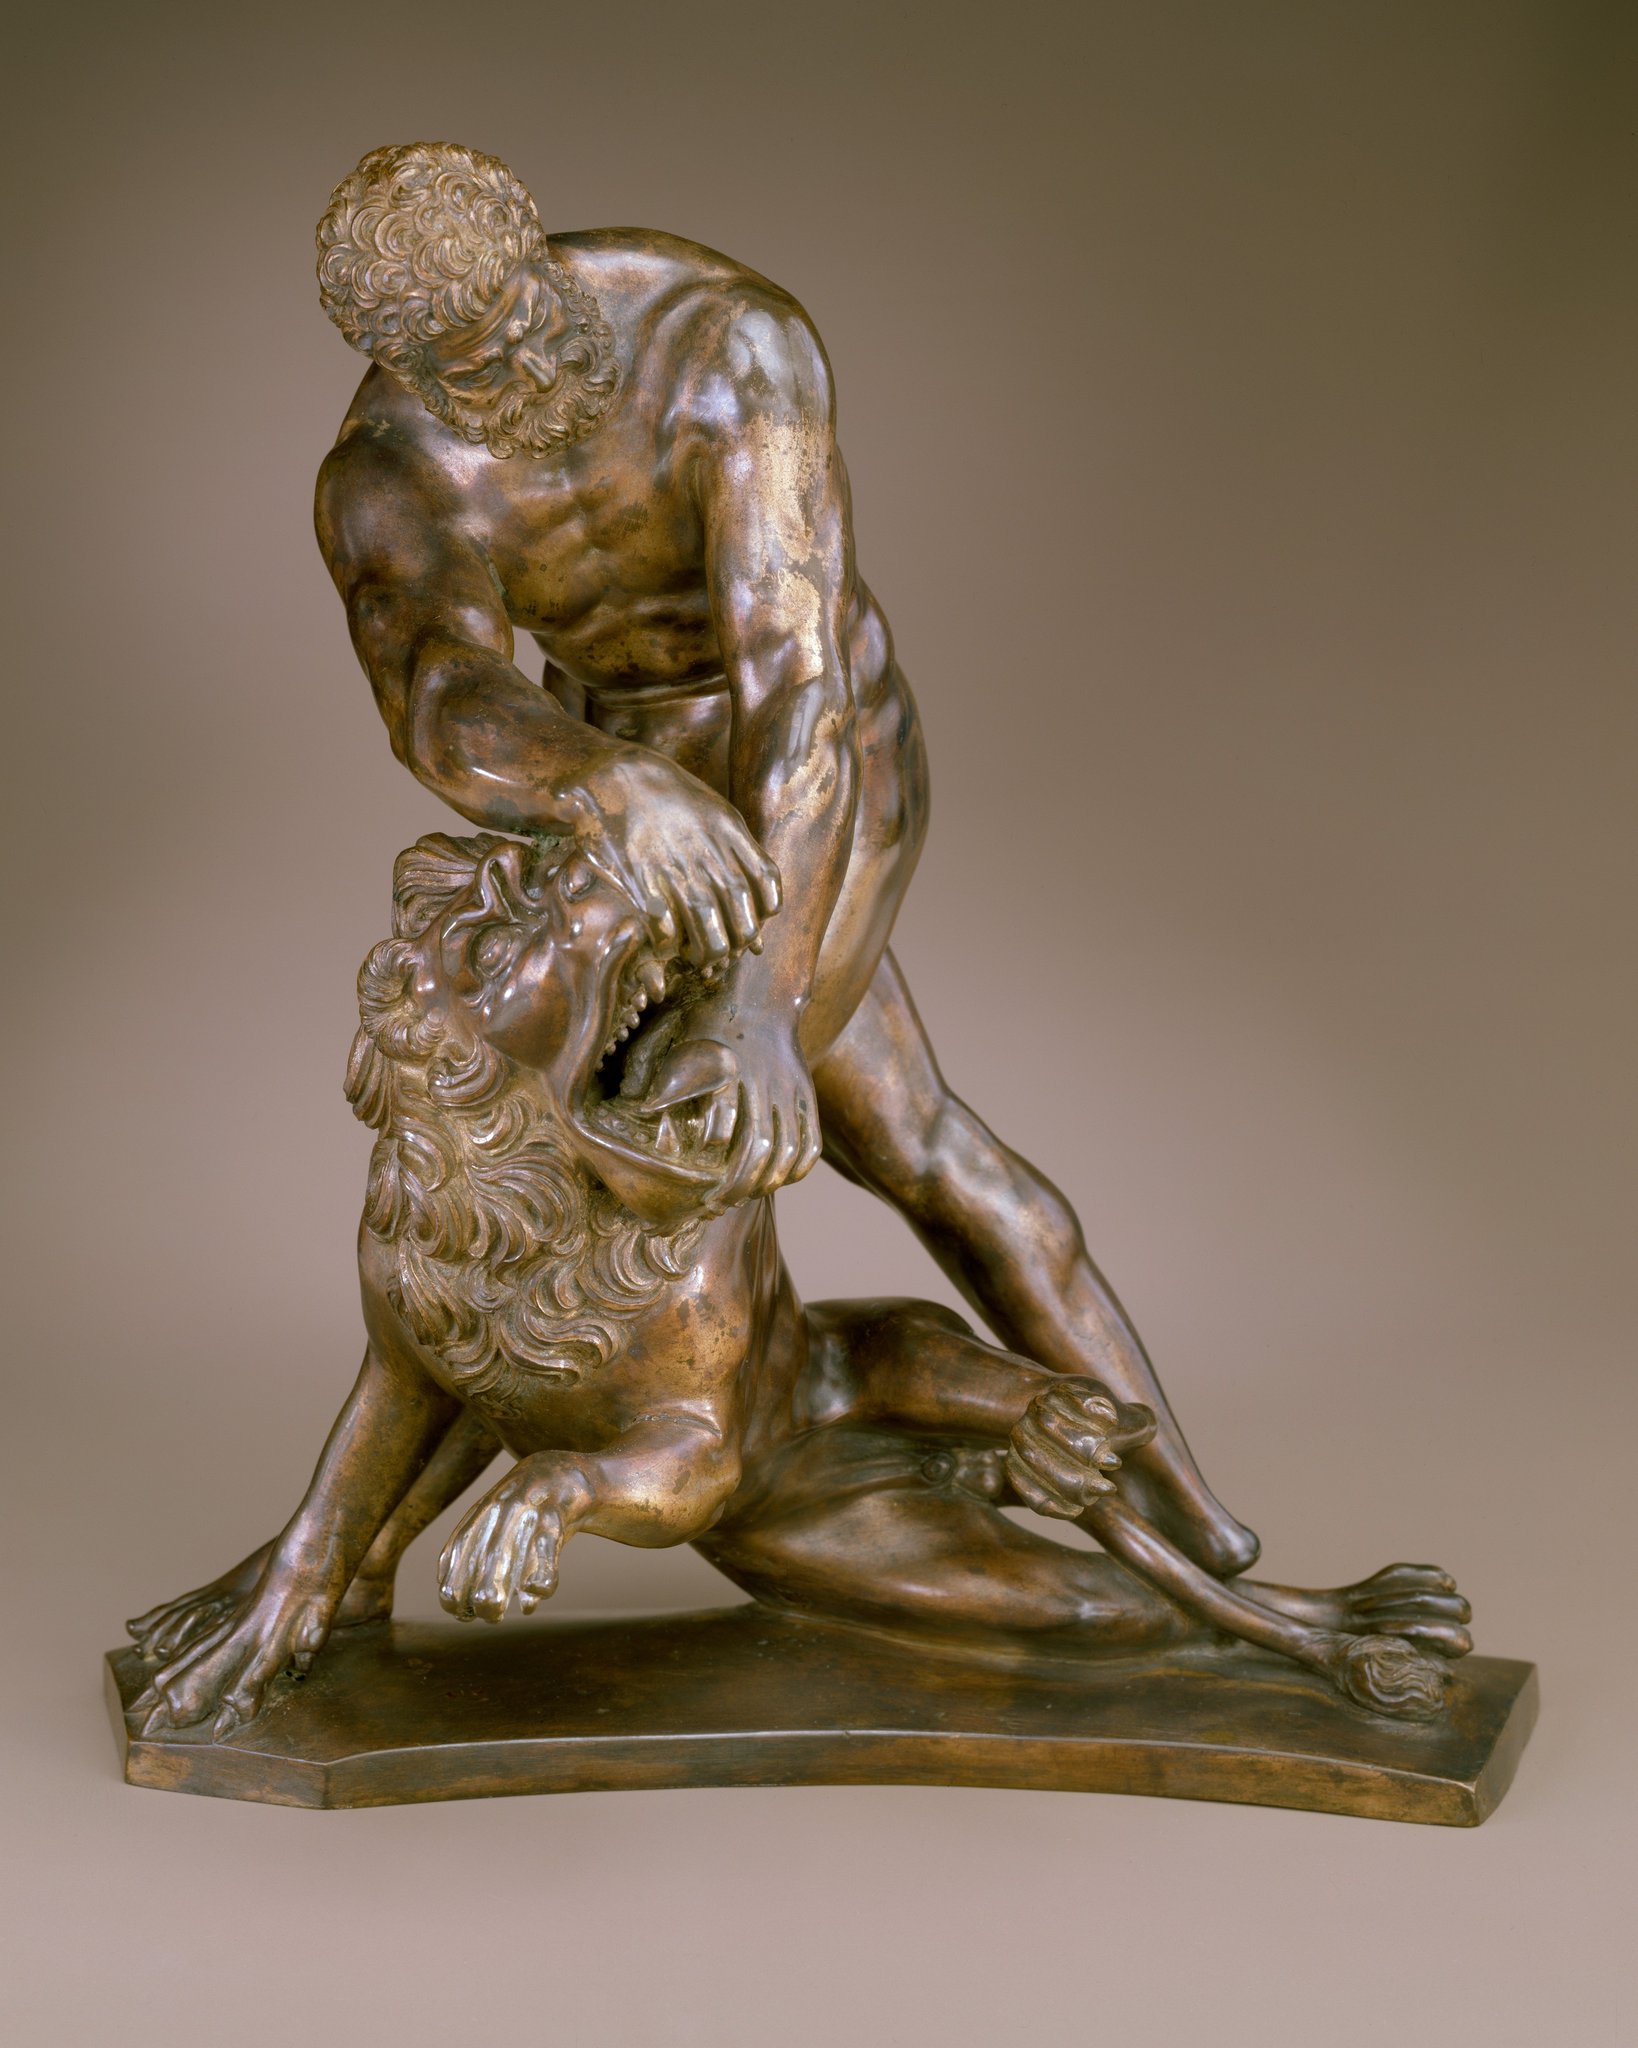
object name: statuette group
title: Hercules and the Nemean Lion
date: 1601-1633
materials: bronze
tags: hercules,lions